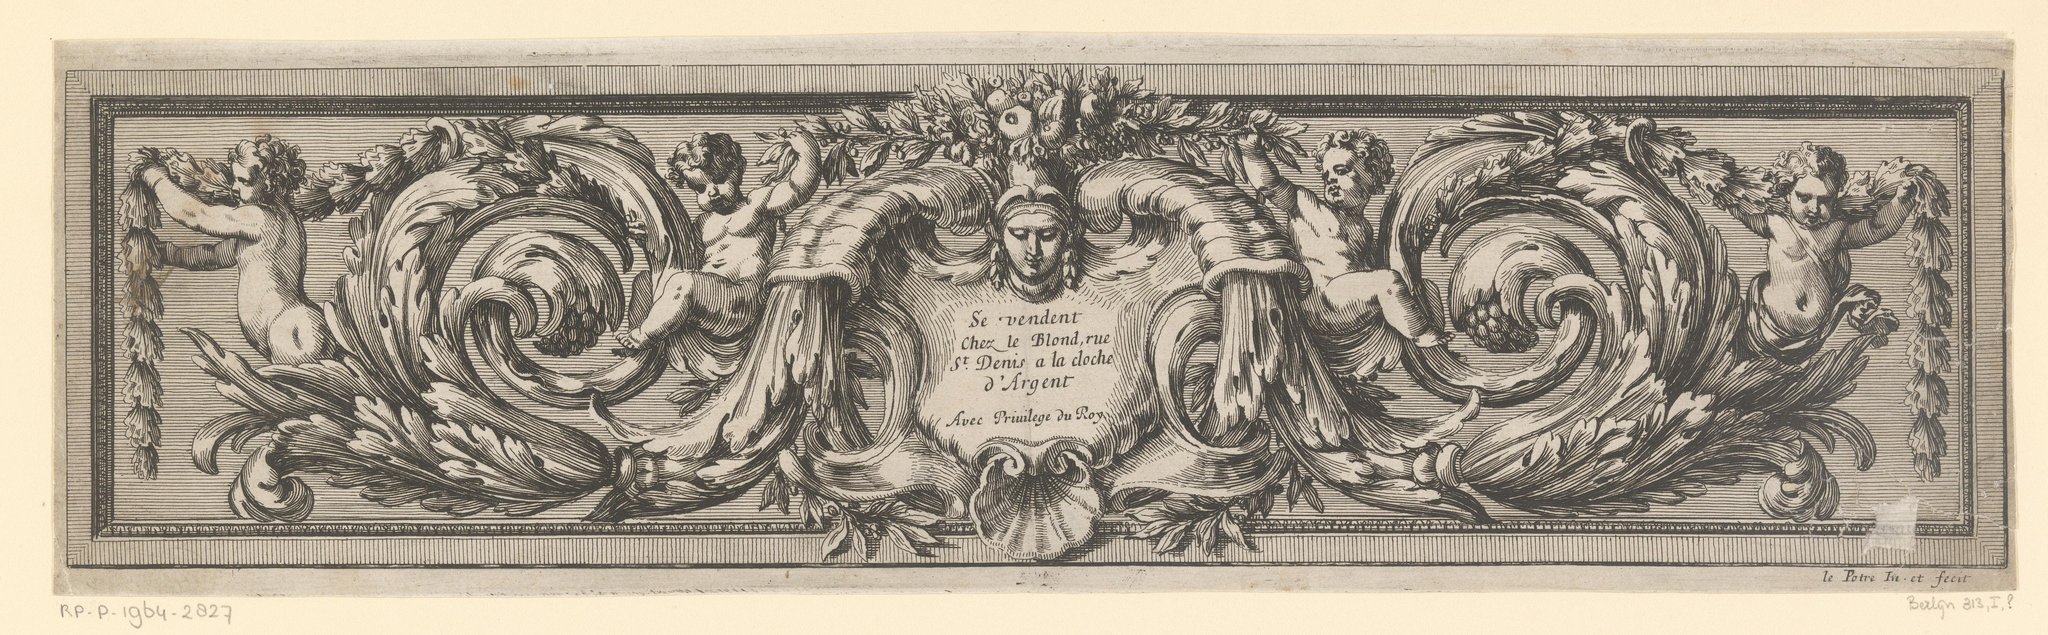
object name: print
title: Fries met putti en acanthusranken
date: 1628-1682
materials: paper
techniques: etching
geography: paris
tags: acanthus ~ ornament, cupids: 'amores', 'amoretti', 'putti'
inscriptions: collector's mark: Lugt 2228, collector's mark: Lugt 2760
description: Een fries met voluten van acanthusranken en vier putti met guirlandes. In het midden een cartouche met adres van de uitgever, een schelpmotief en aan de bovenzijde een vrouwelijk masker met bloemen.